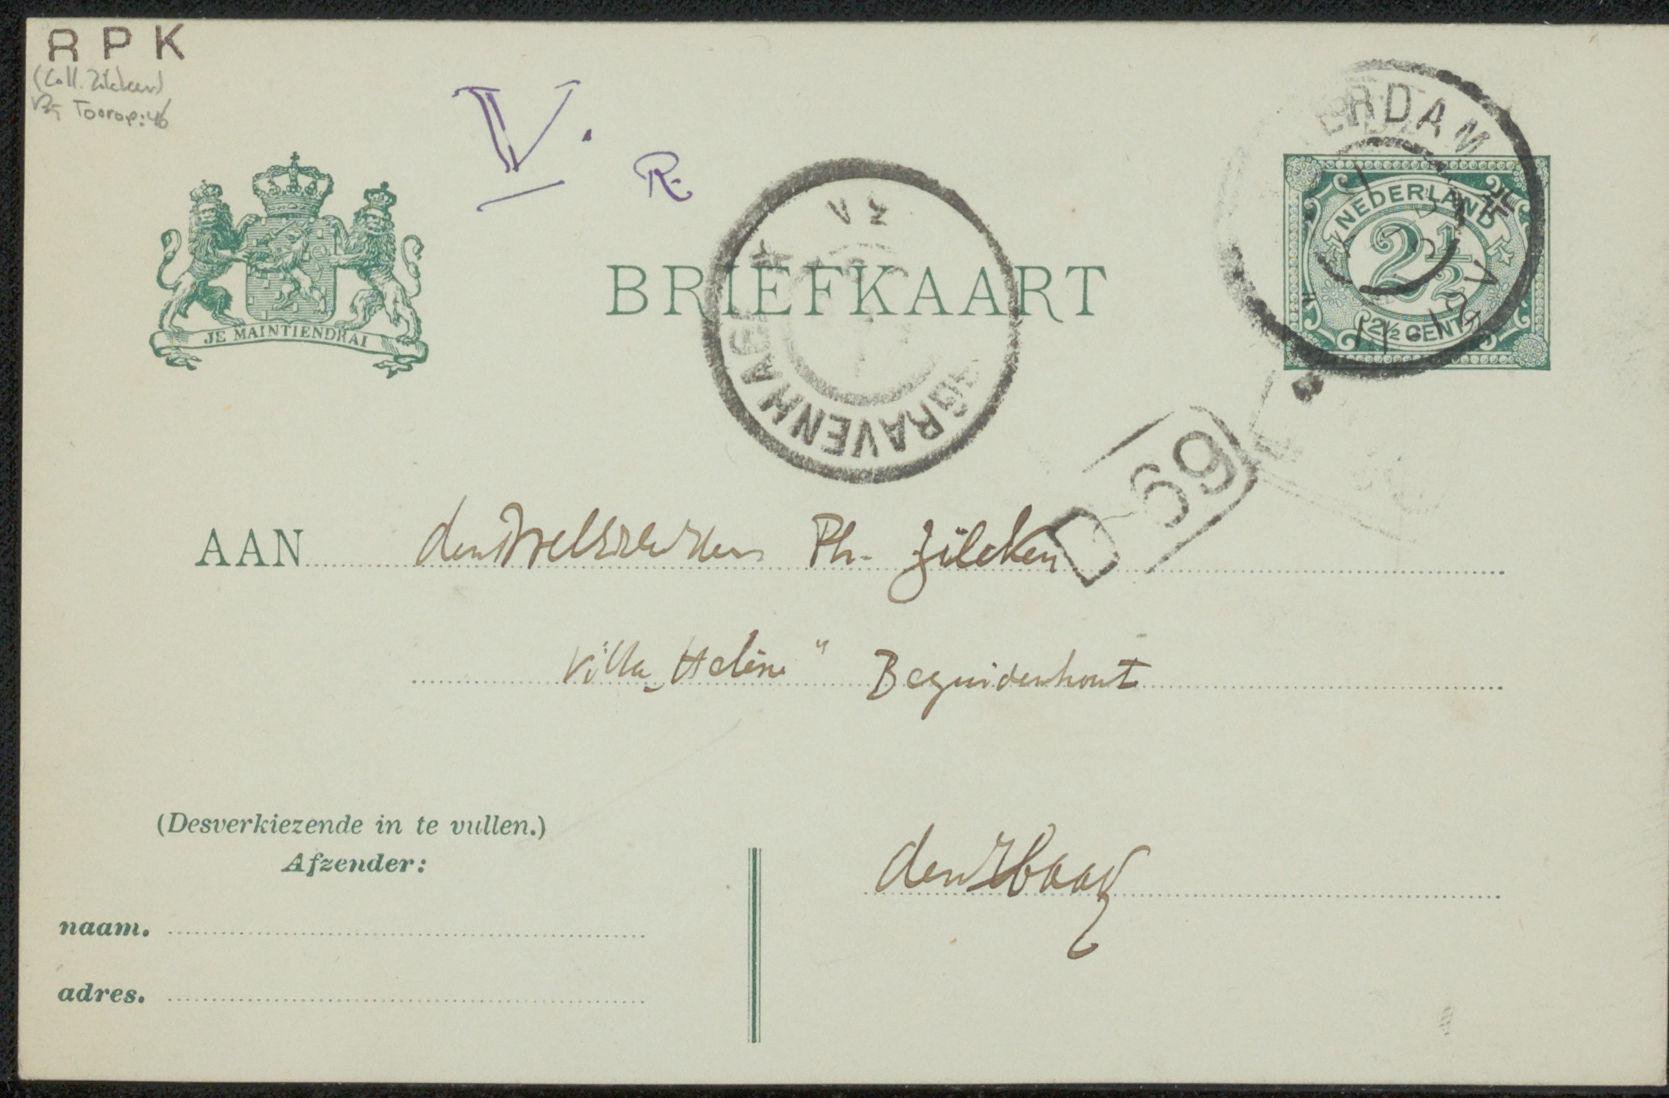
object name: postcard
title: Briefkaart aan Philip Zilcken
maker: jan toorop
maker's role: draughtsman, painter, print maker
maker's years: 1858-1928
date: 1905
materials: cardboard, ink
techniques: pen, writing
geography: amsterdam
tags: philip zilcken, the graphic arts, workshop, studio of the artist (in general), exhibition ~ art, venice, amsterdam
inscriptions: collector's mark: ‘RPK’